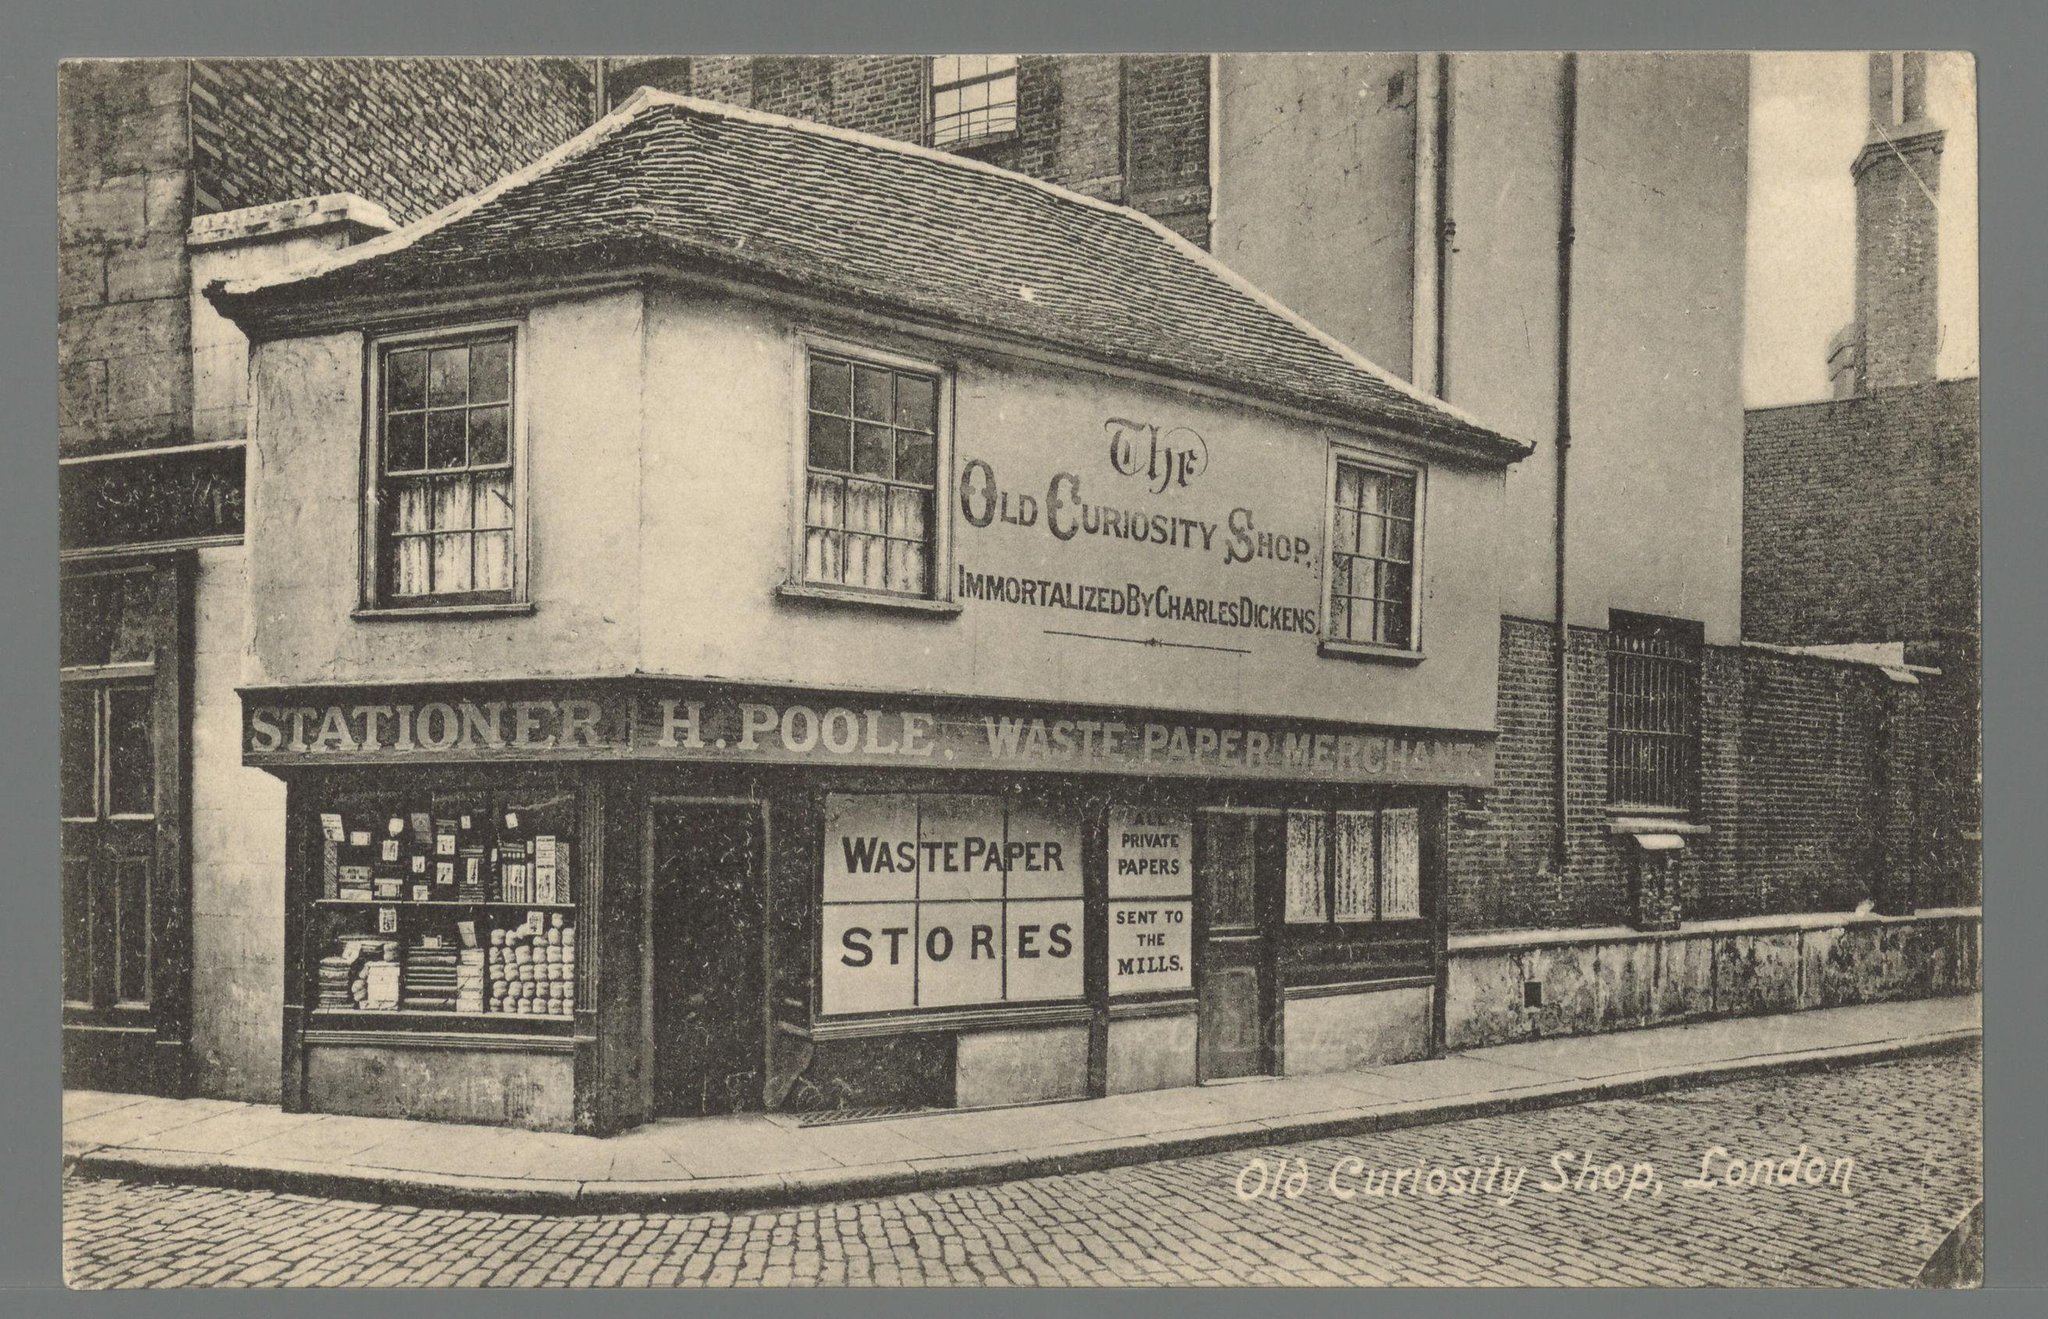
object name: ansichtkaart, prentbriefkaart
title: Old Curiosity Shop, London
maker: Anonymous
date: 1902-1930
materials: cardboard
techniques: photograph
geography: great britain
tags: shop, store, london